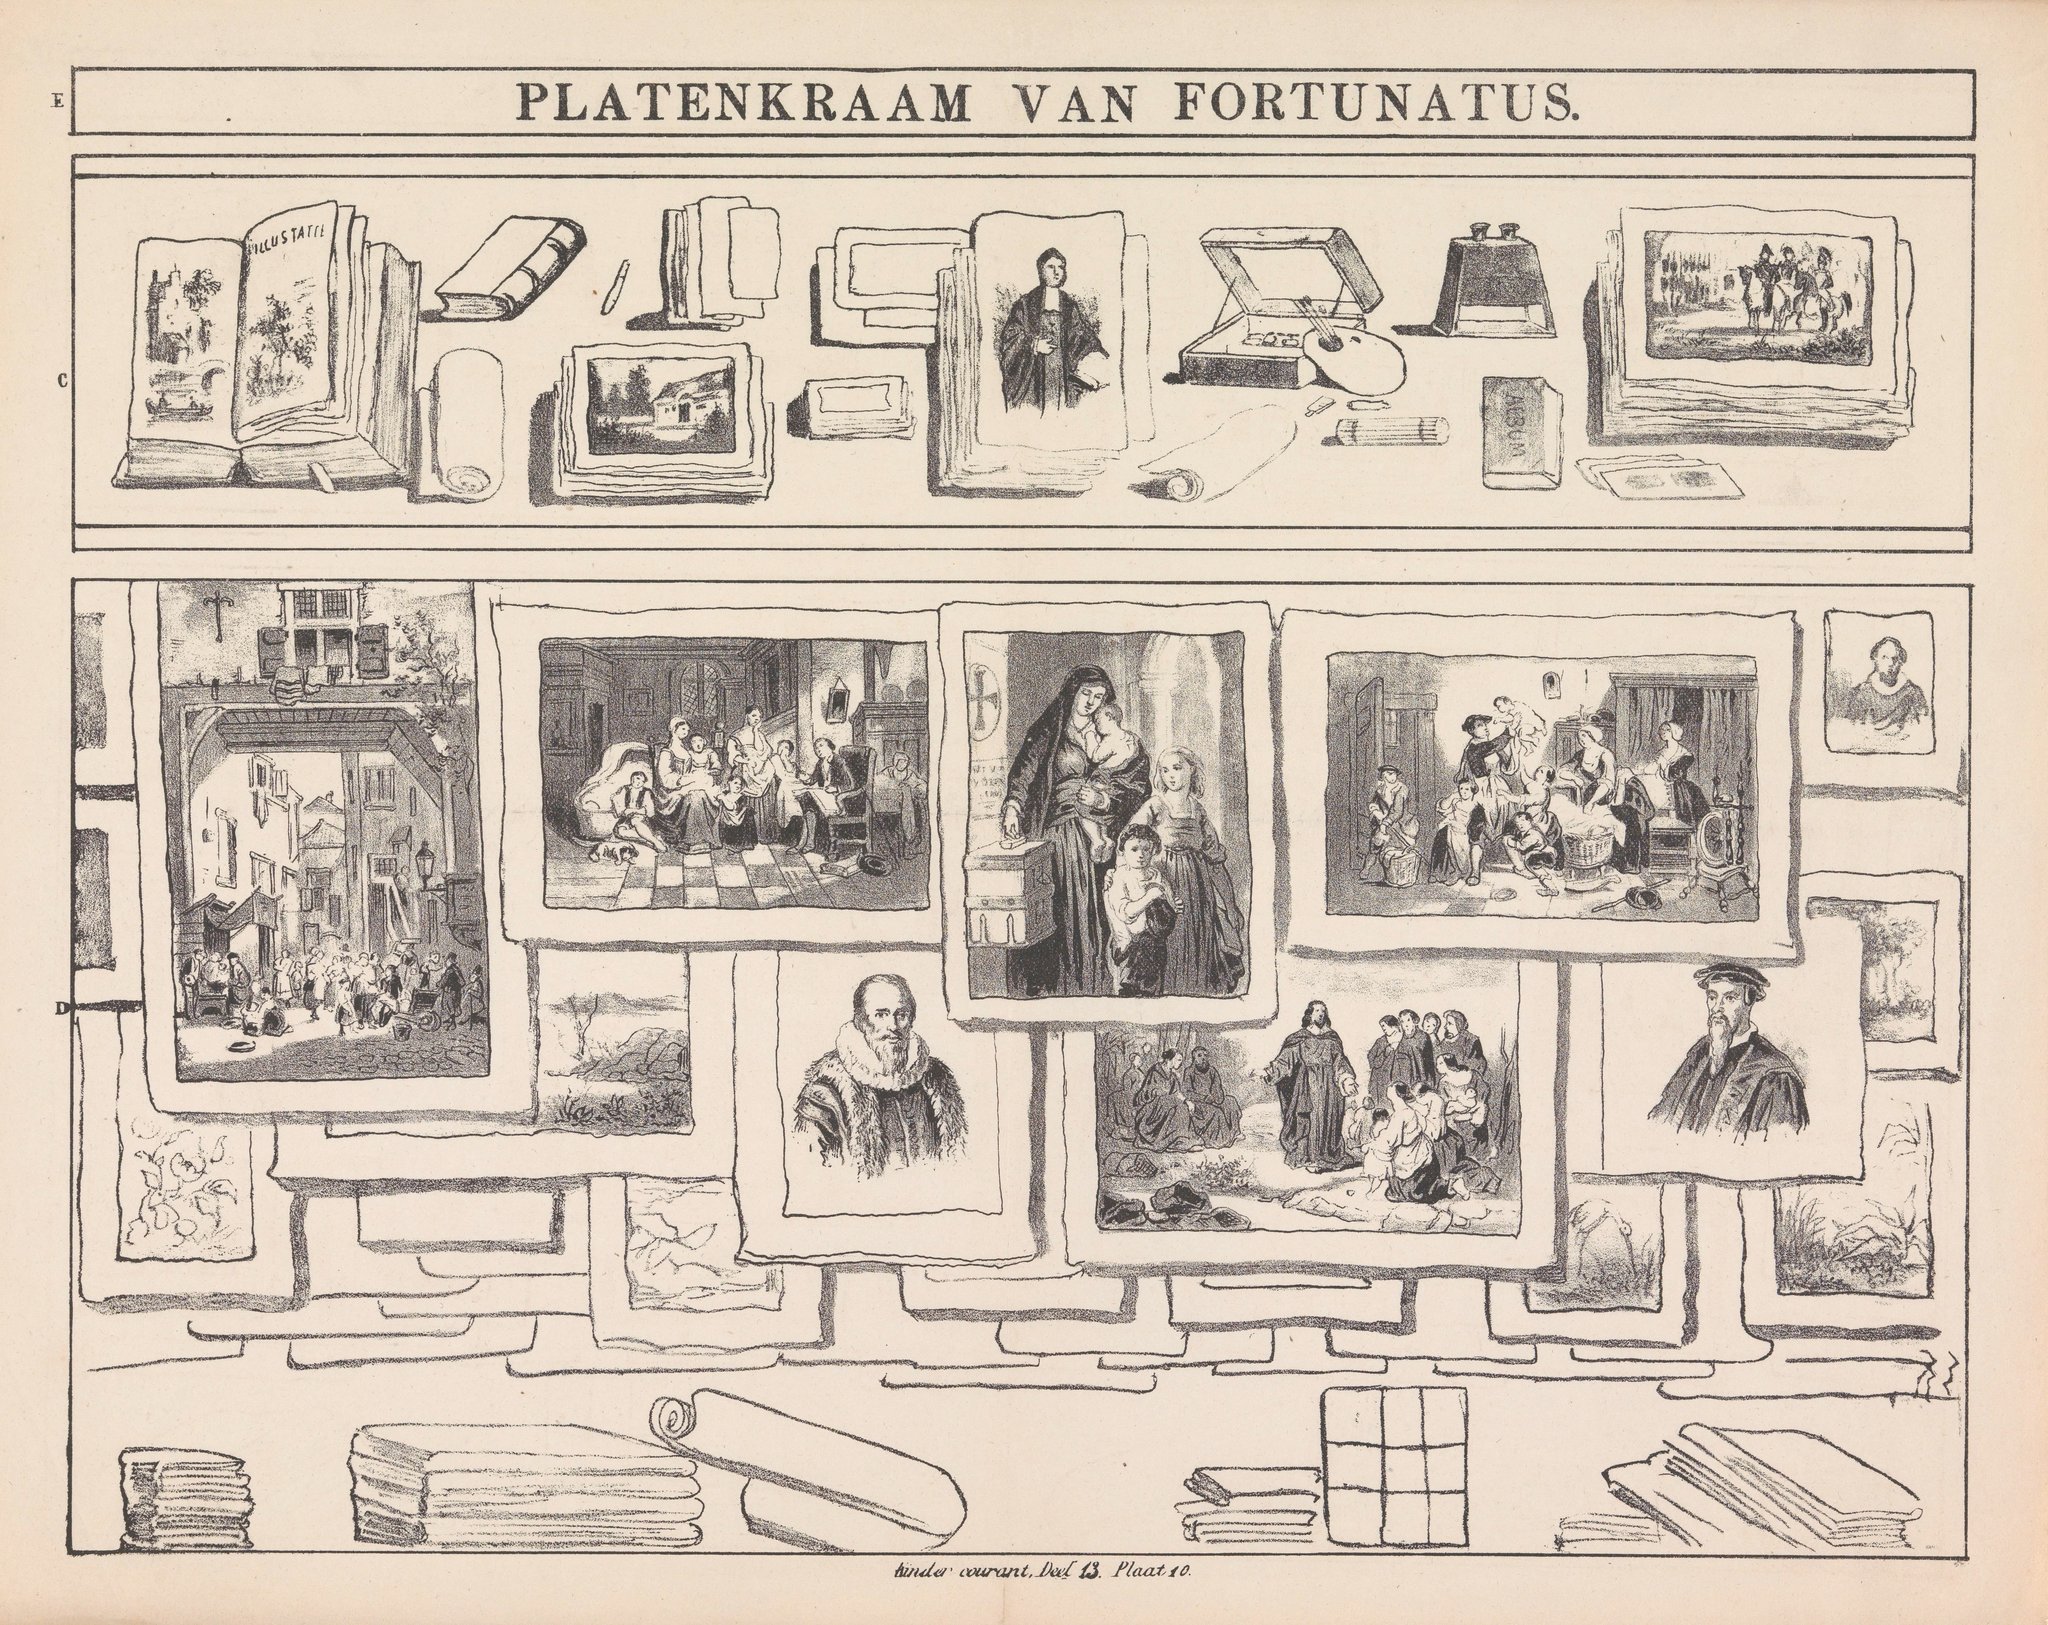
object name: print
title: Bouwplaat voor een prentenkraam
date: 1884-1901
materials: paper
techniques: lithograph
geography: the hague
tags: print, e.g.: engraving, etching, lithograph, art dealer (+ graphic arts), tools, implements of painter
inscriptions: collector's mark: Lugt 2228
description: Deze plaat met de letters E, C en D en maakt deel uit van de bouwplaat 'Platenkraam van Fortunatus'. Onder genummerd: Kinder Courant Deel 13, Plaat 10.